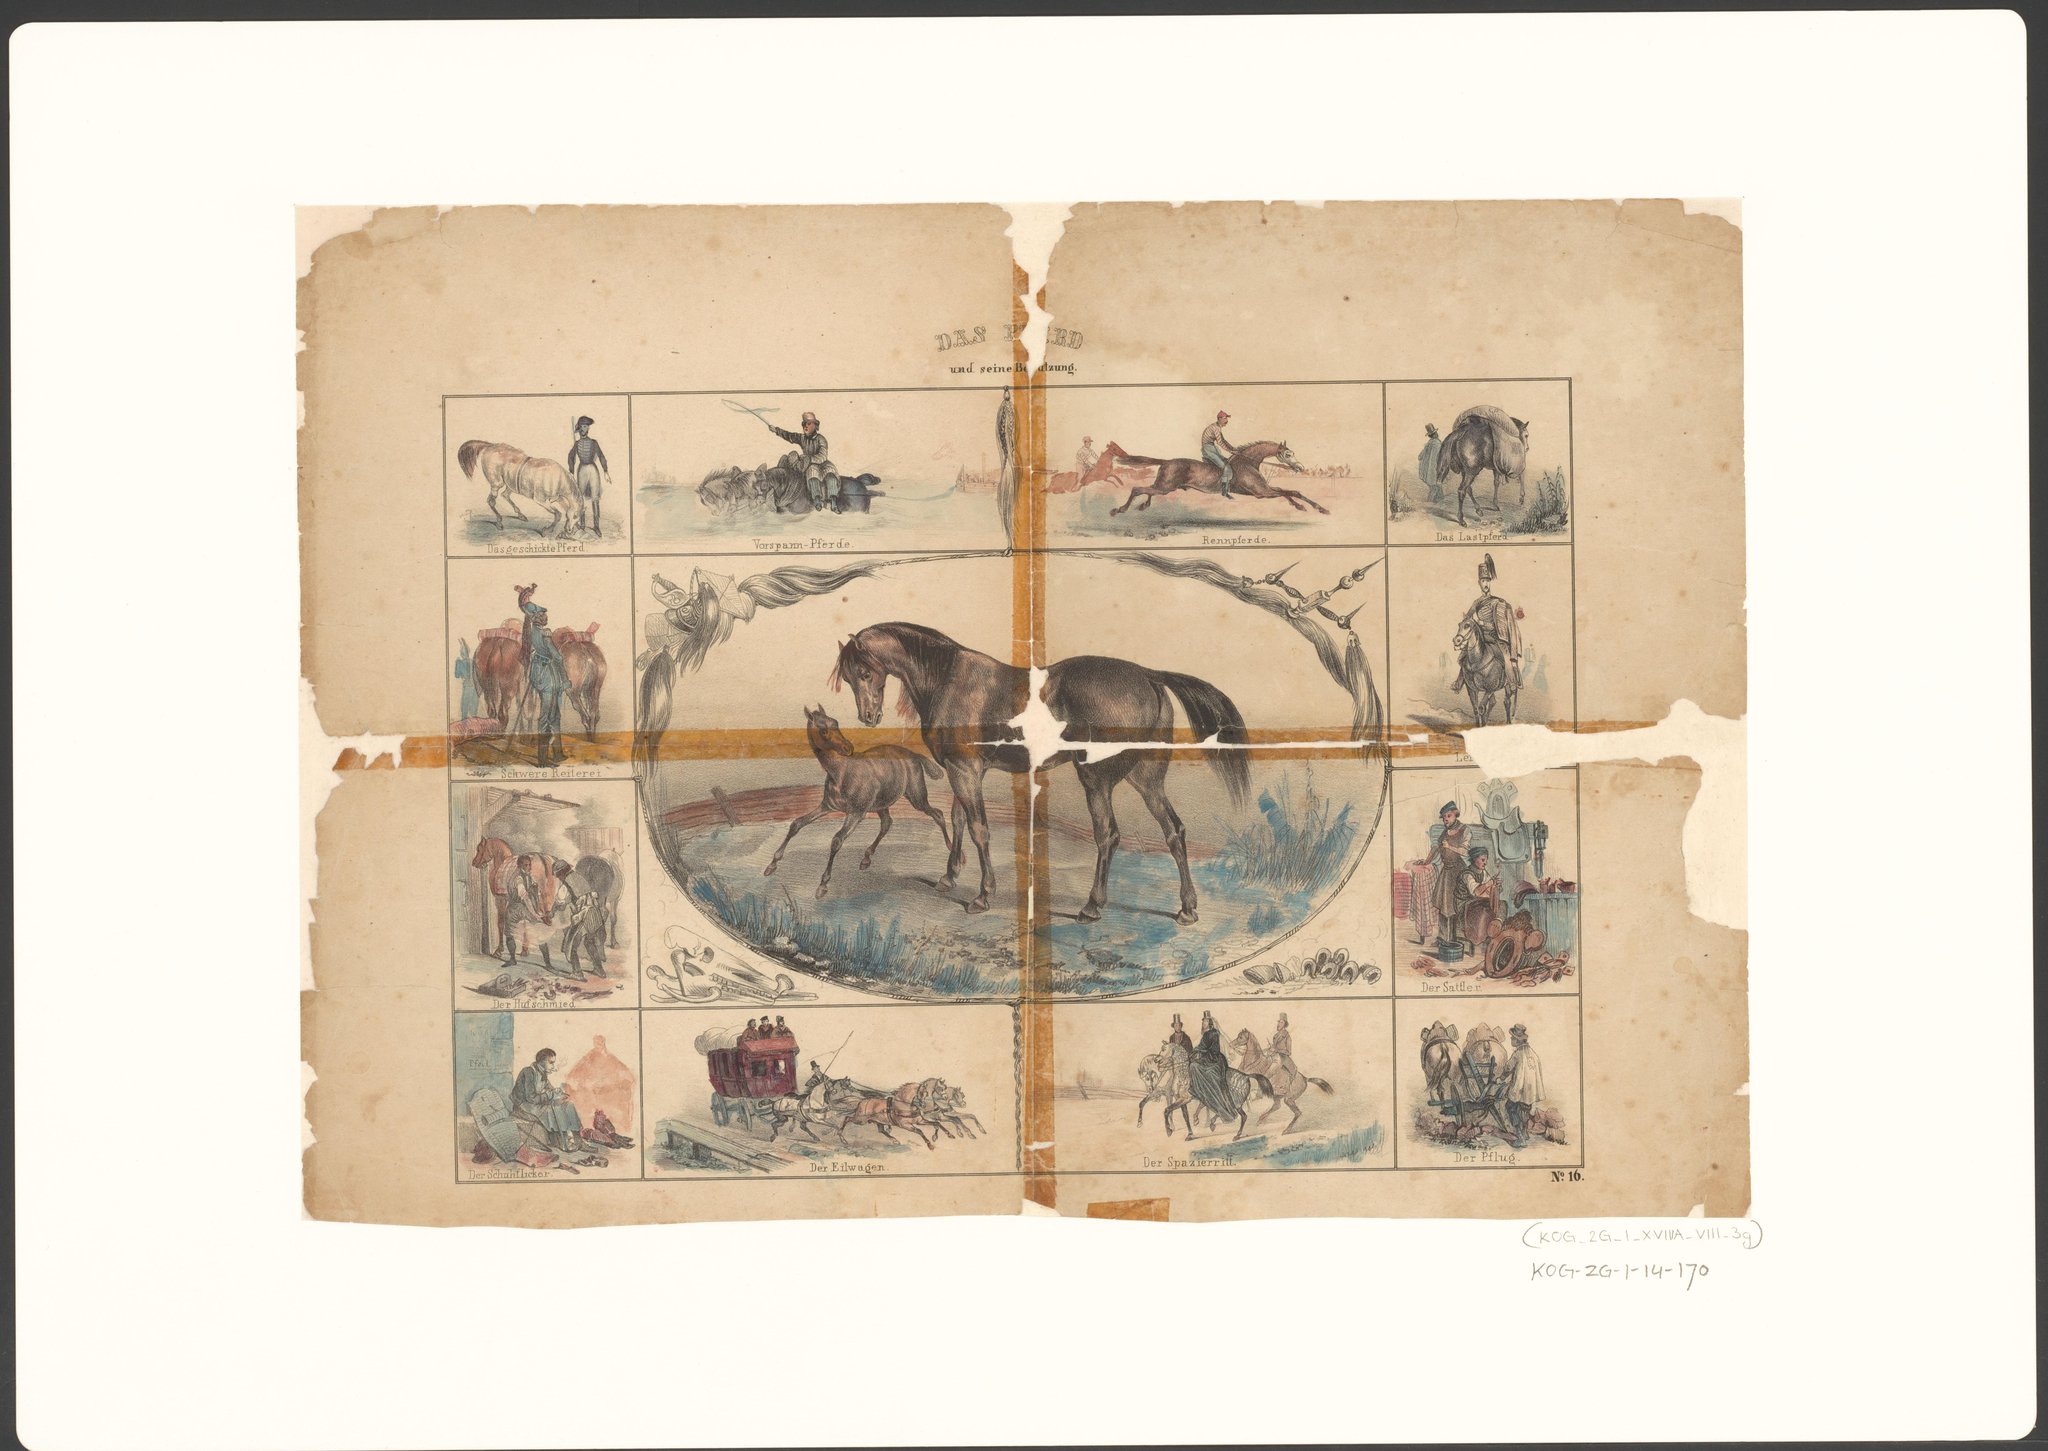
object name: print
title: Das Pferd und seine Benutzung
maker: Anonymous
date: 1850-1920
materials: paper, watercolor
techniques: lithograph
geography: germany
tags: farrier, shoeing-smith, horse, crafts and industries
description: Blad met centraal een paard met een veulen, daaromheen kleine voorstellingen van paarden en toebehoren. Rechtsonder genummerd: No. 16. Onderwerpsrubrieken binnen de Atlas Zeden en Gewoonten: Mannelijk beroep en bedrijf: Varia en kinderprenten betrekkelijk het onderwerp.